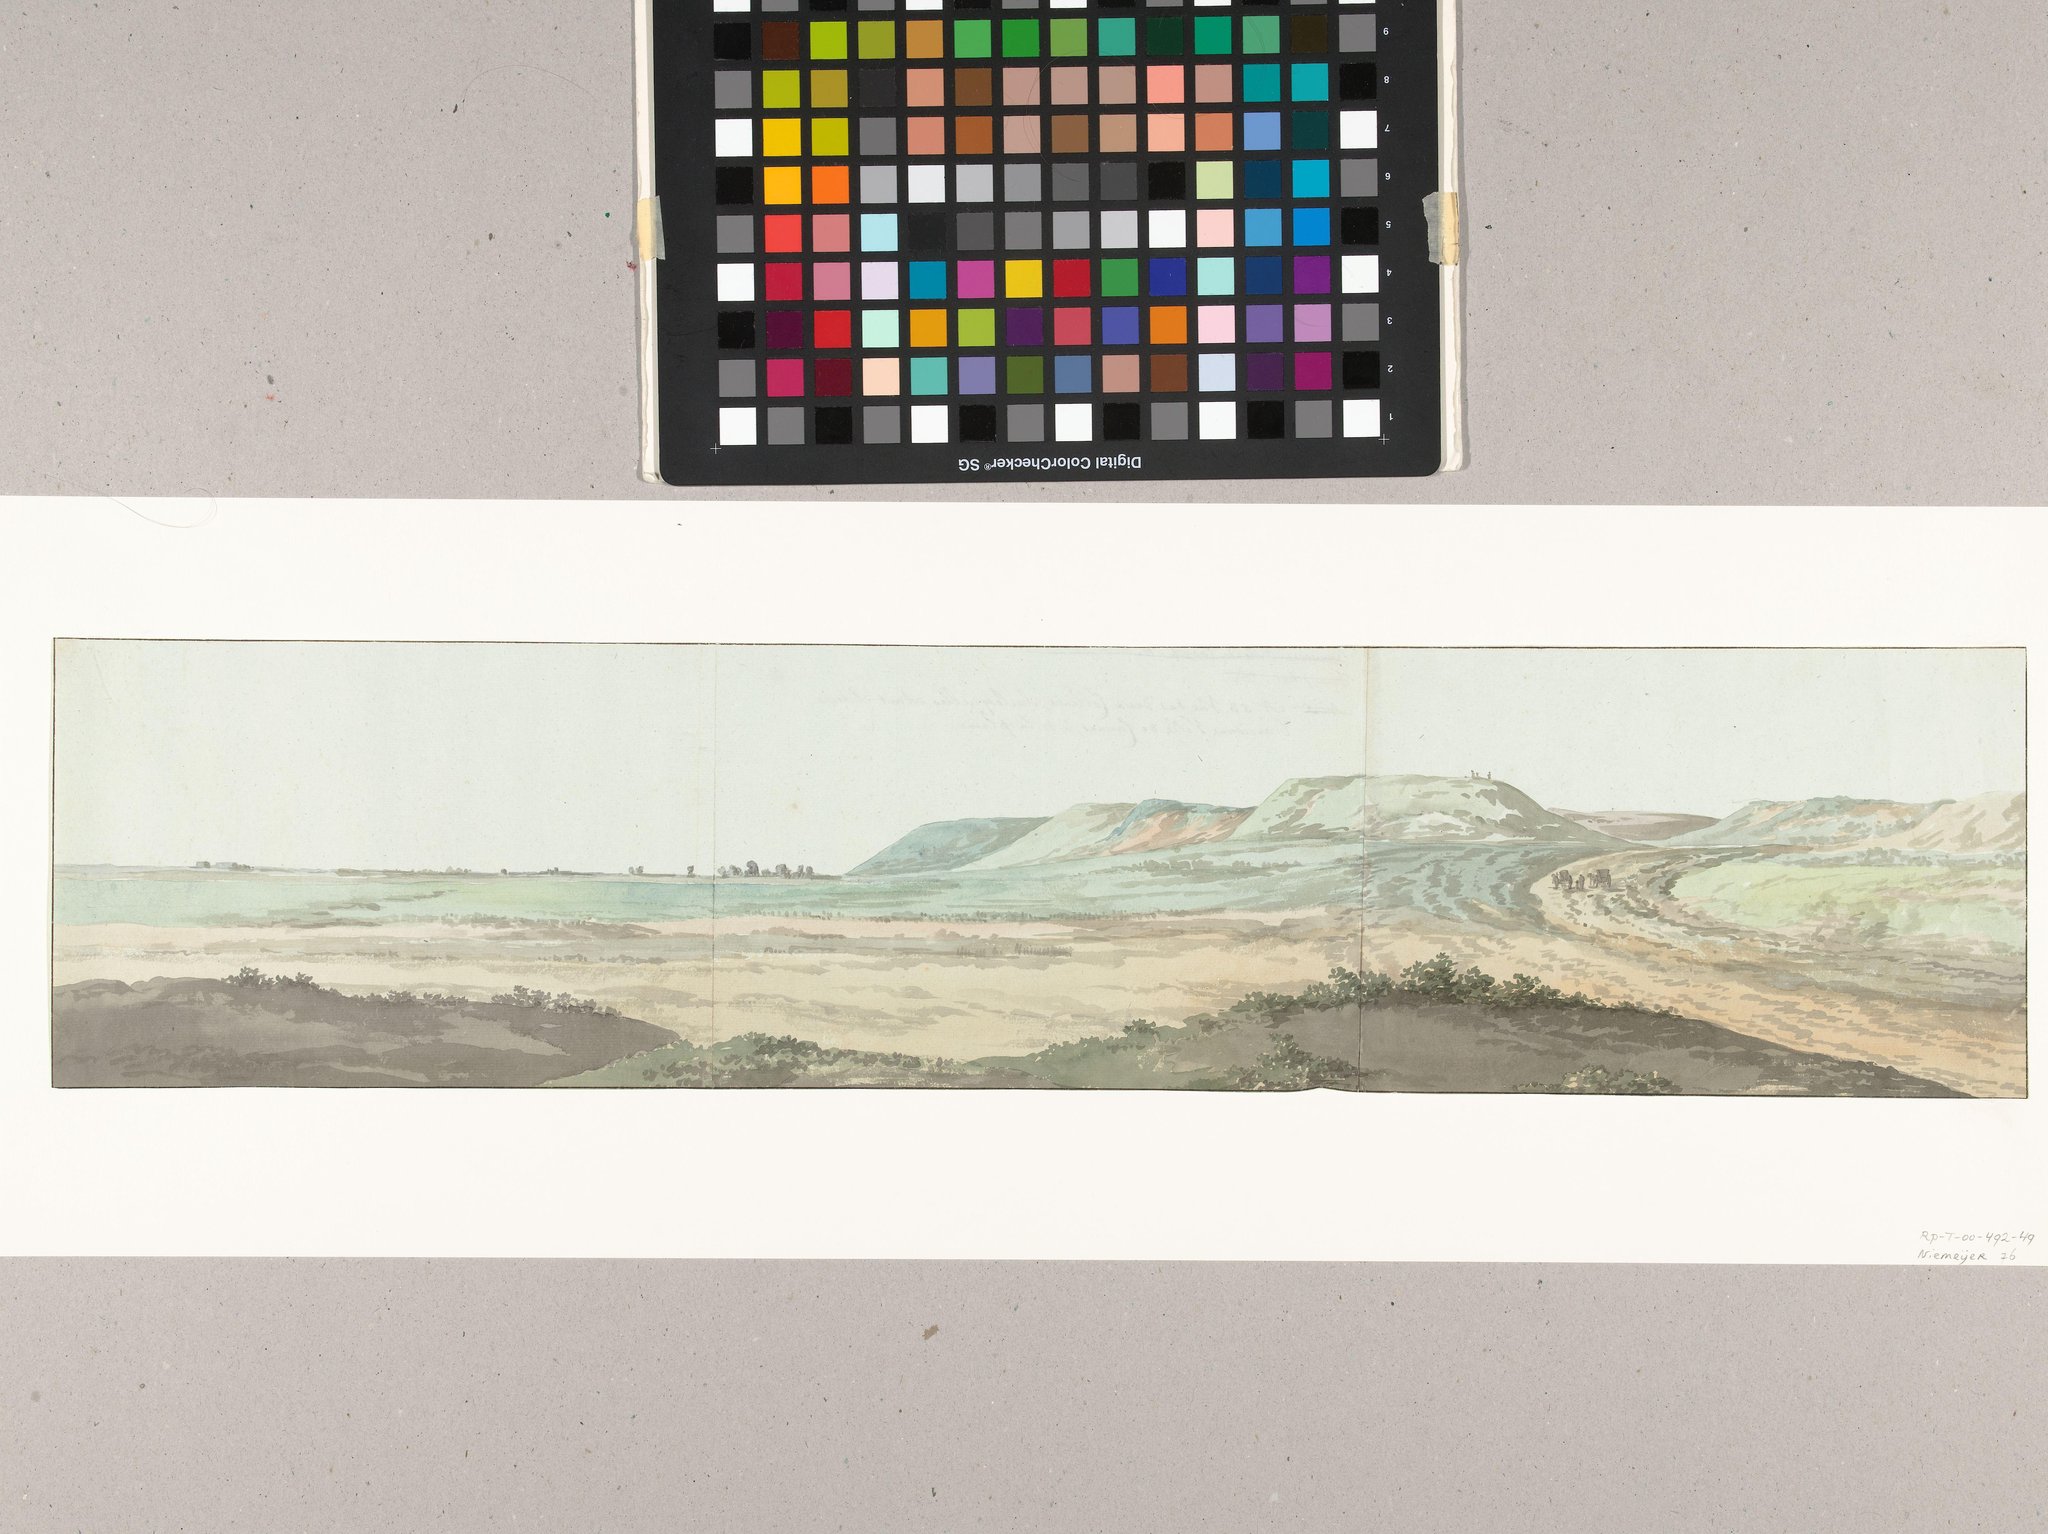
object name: drawing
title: Vue des deus Collines sur lesquelles était située l'ancienne Cannes & de la plaine environs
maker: louis ducros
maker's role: draughtsman, print maker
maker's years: 1748-1810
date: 1778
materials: paper, watercolor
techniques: brush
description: Tekening uit het album 'Voyage en Italie, en Sicile et à Malte', 1778.